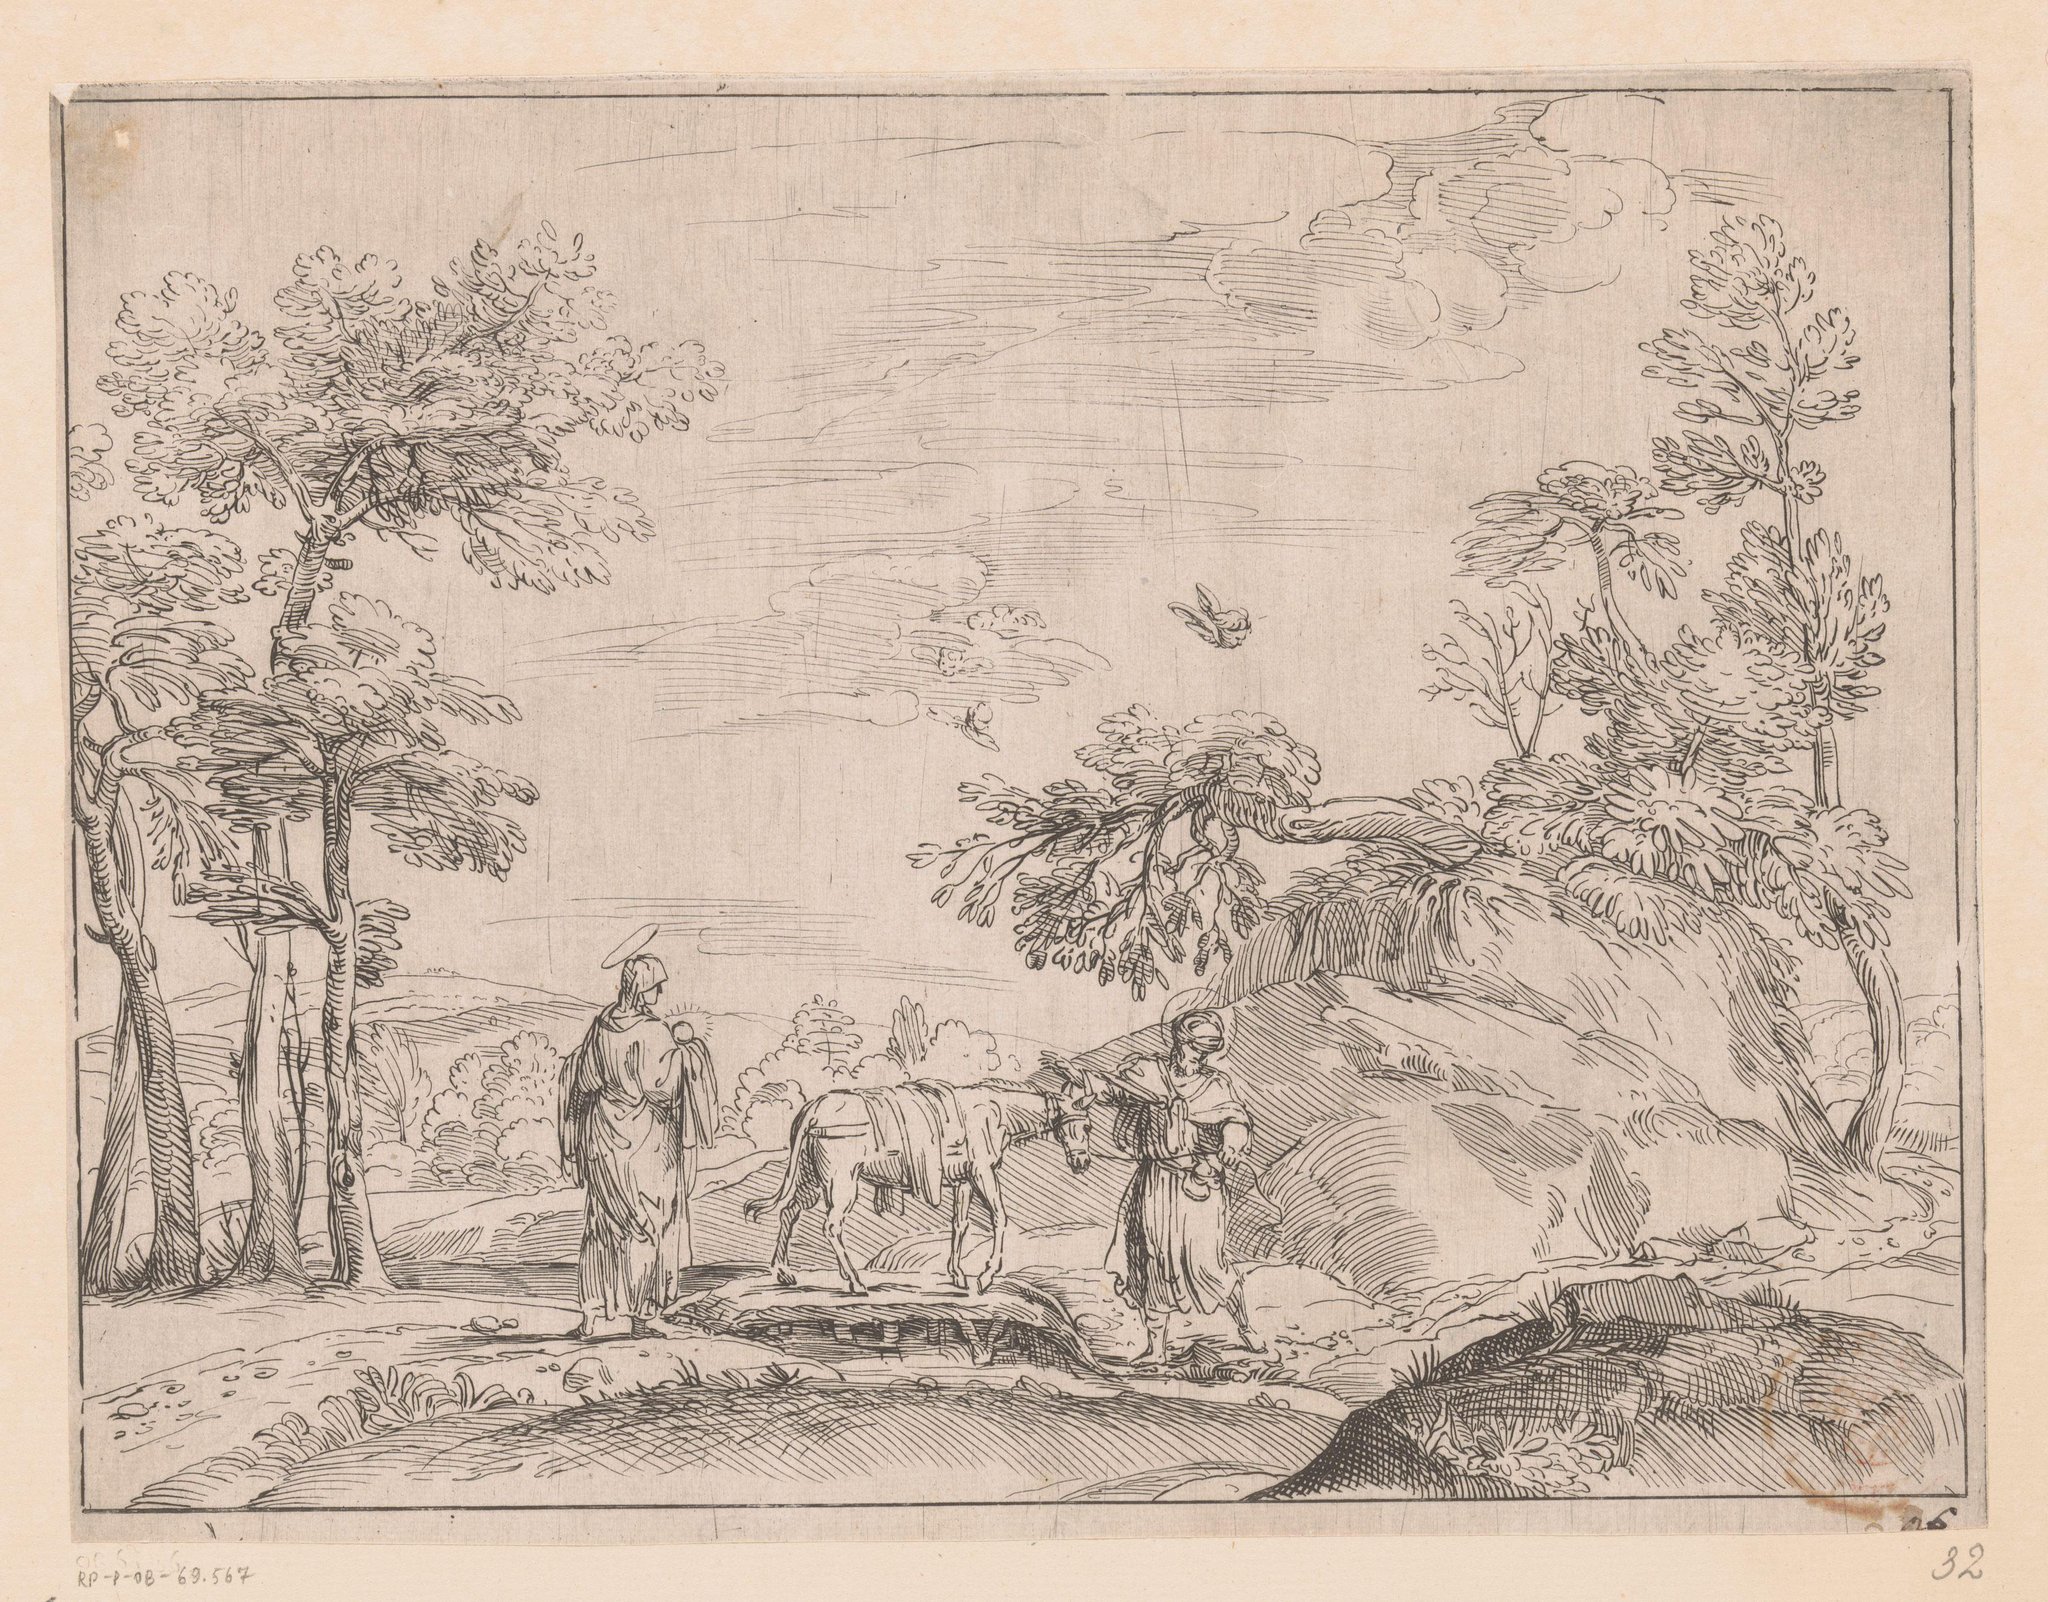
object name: print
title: Vlucht naar Egypte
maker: charles macé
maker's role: draughtsman, print maker, sculptor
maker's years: 1631-1665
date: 1641-1665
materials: paper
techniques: etching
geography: france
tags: the flight into egypt: mary, joseph, the child (and sometimes others) on their way; mary usually riding on an ass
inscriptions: watermark, collector's mark: Lugt 240